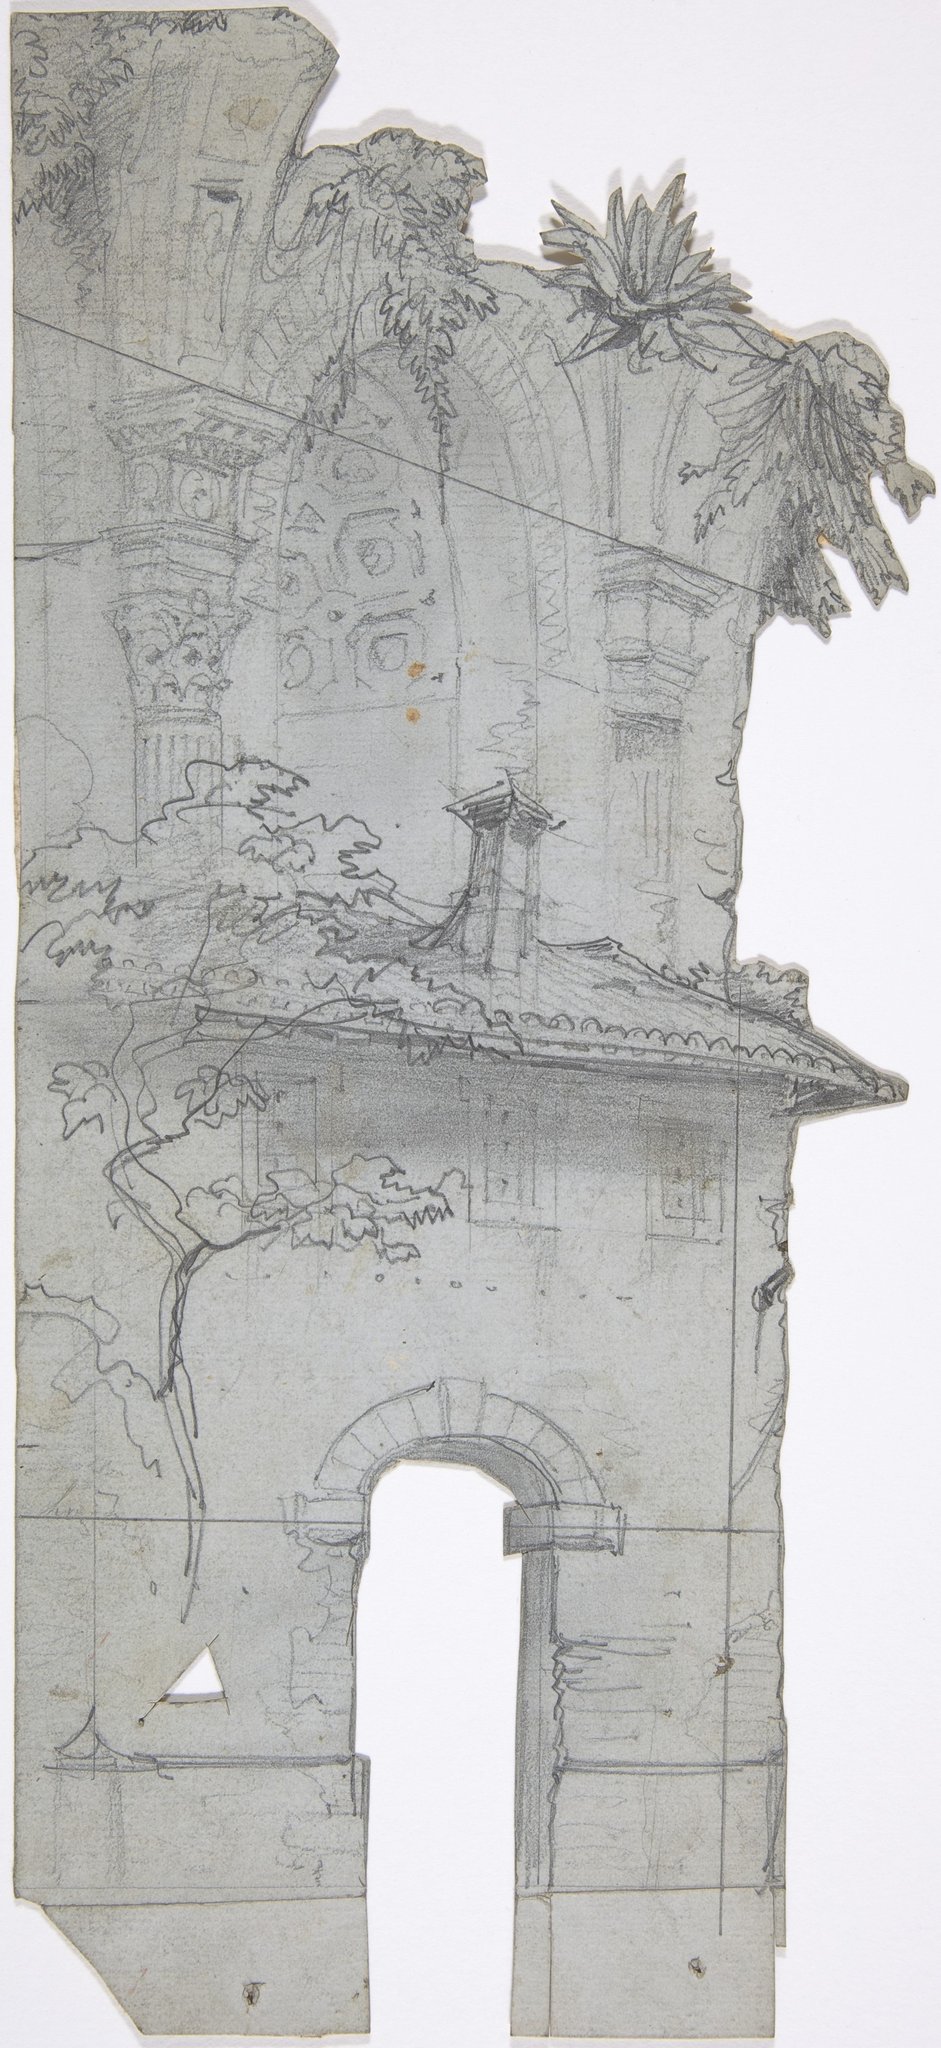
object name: drawing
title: Design for a Stage Set at the Opéra, Paris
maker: eugène cicéri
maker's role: artist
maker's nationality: french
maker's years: 1813-1890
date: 1830-1890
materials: graphite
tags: stage design